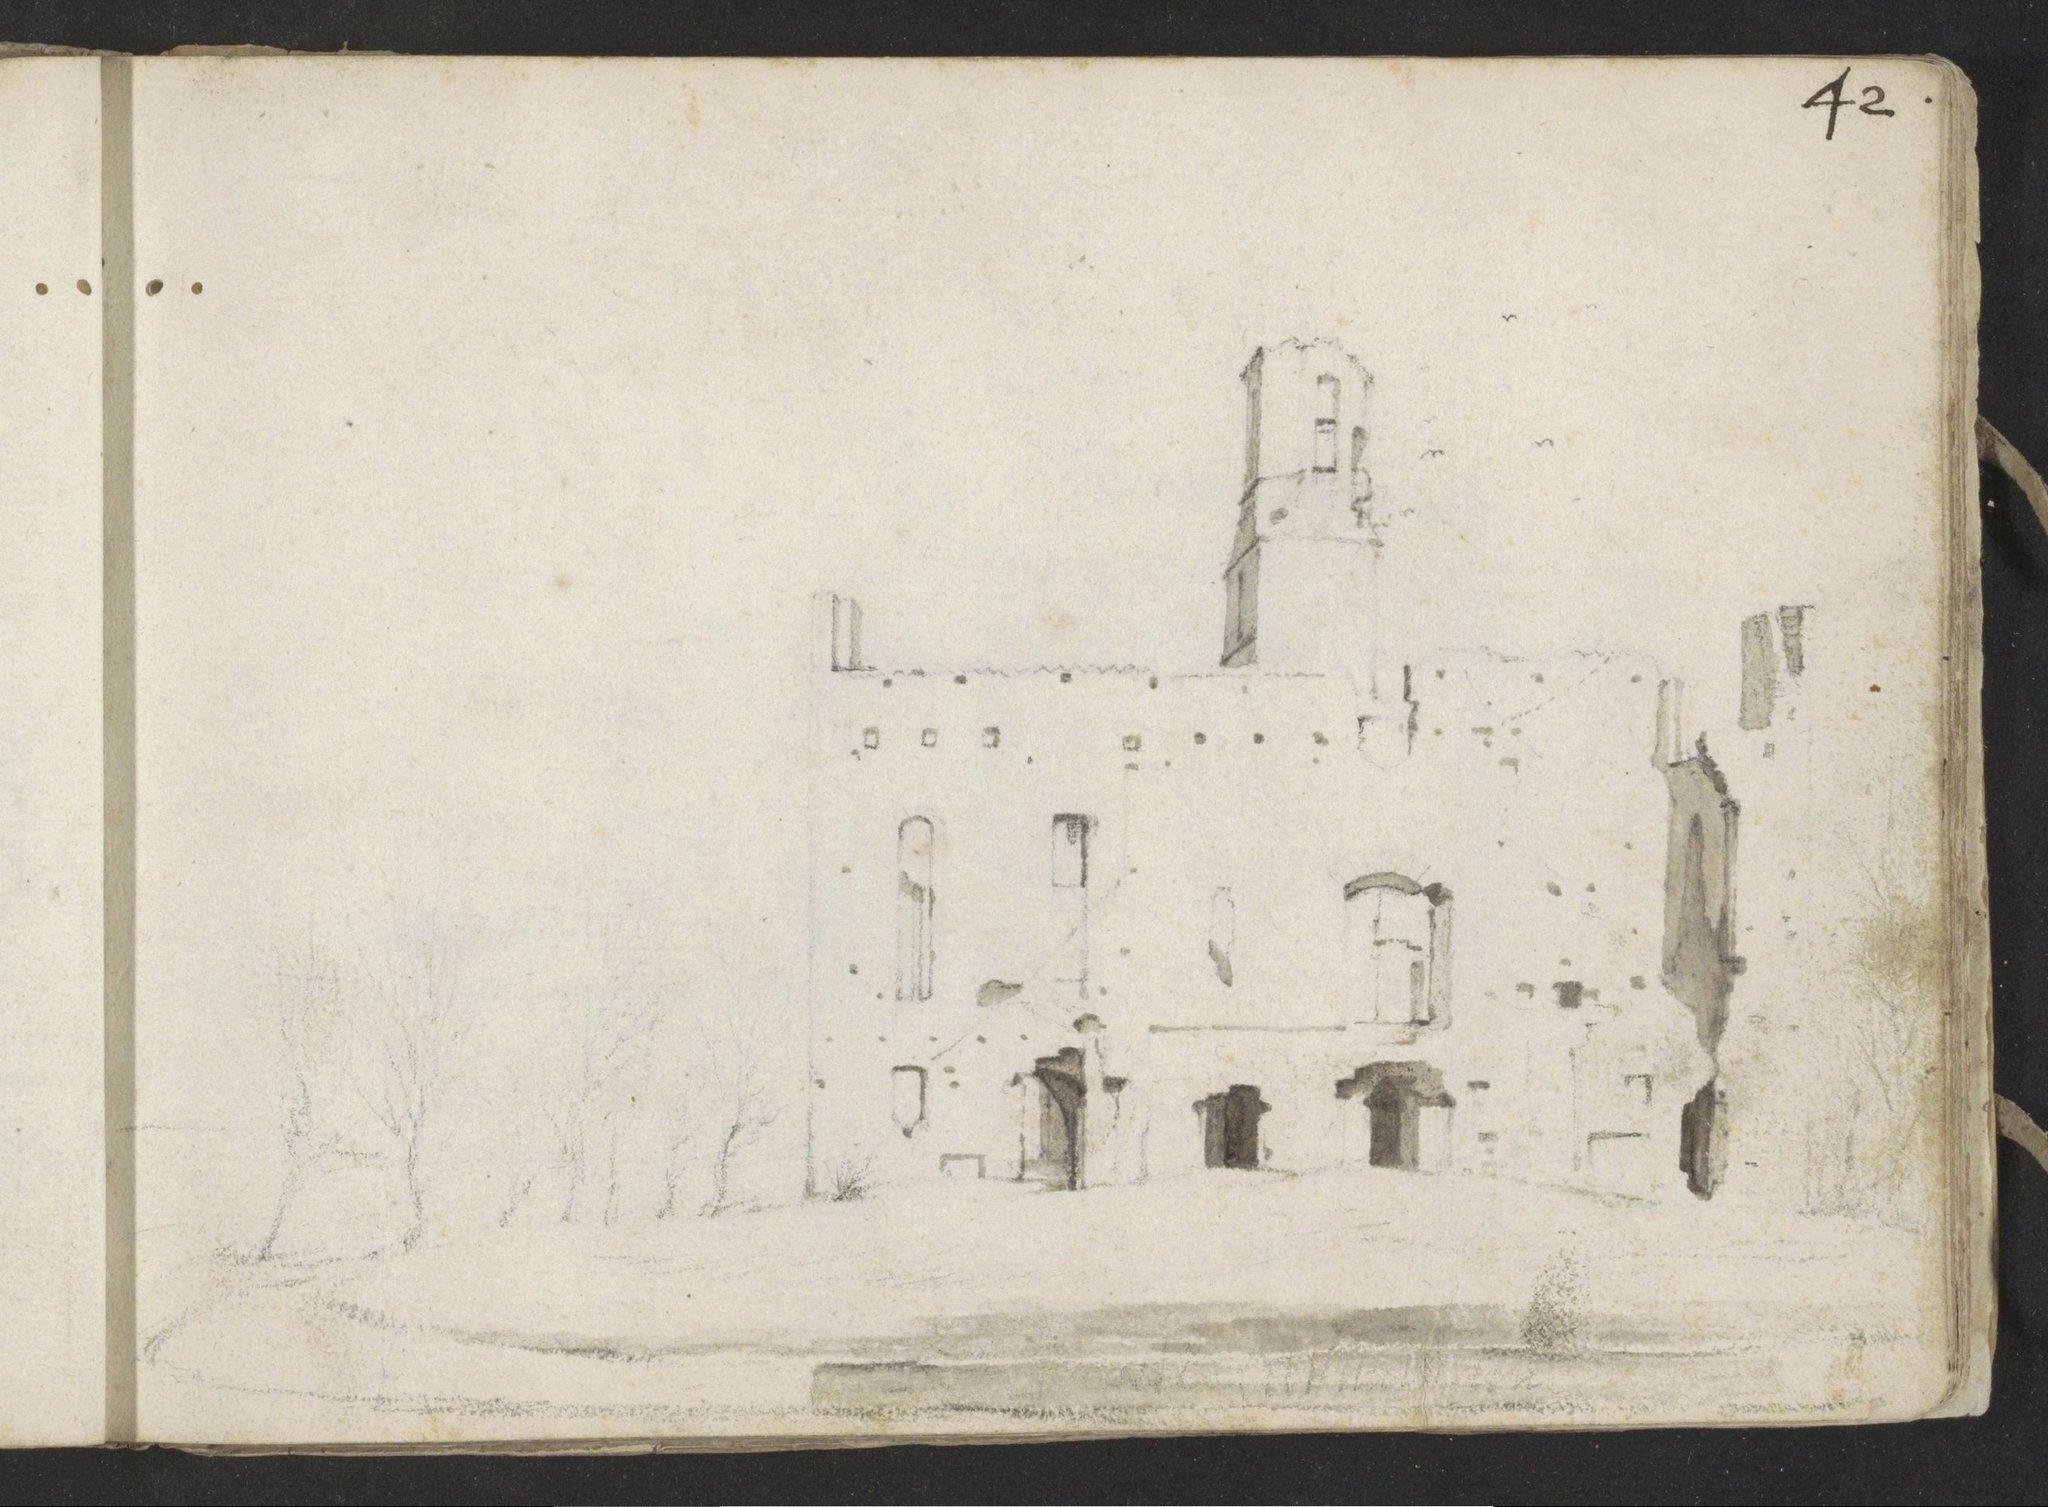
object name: sketchbook leaf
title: Ruïne van Huis Kranenburg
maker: gerard ter borch (ii)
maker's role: draughtsman, painter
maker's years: 1617-1681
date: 1633-1634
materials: ink, paper, pencil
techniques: brush, pen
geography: berkum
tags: ruin of a dwelling, house, castle, etc.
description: Vanuit het zuidoosten gezien. Blad 42 recto uit een schetsboek met 55 bladen.